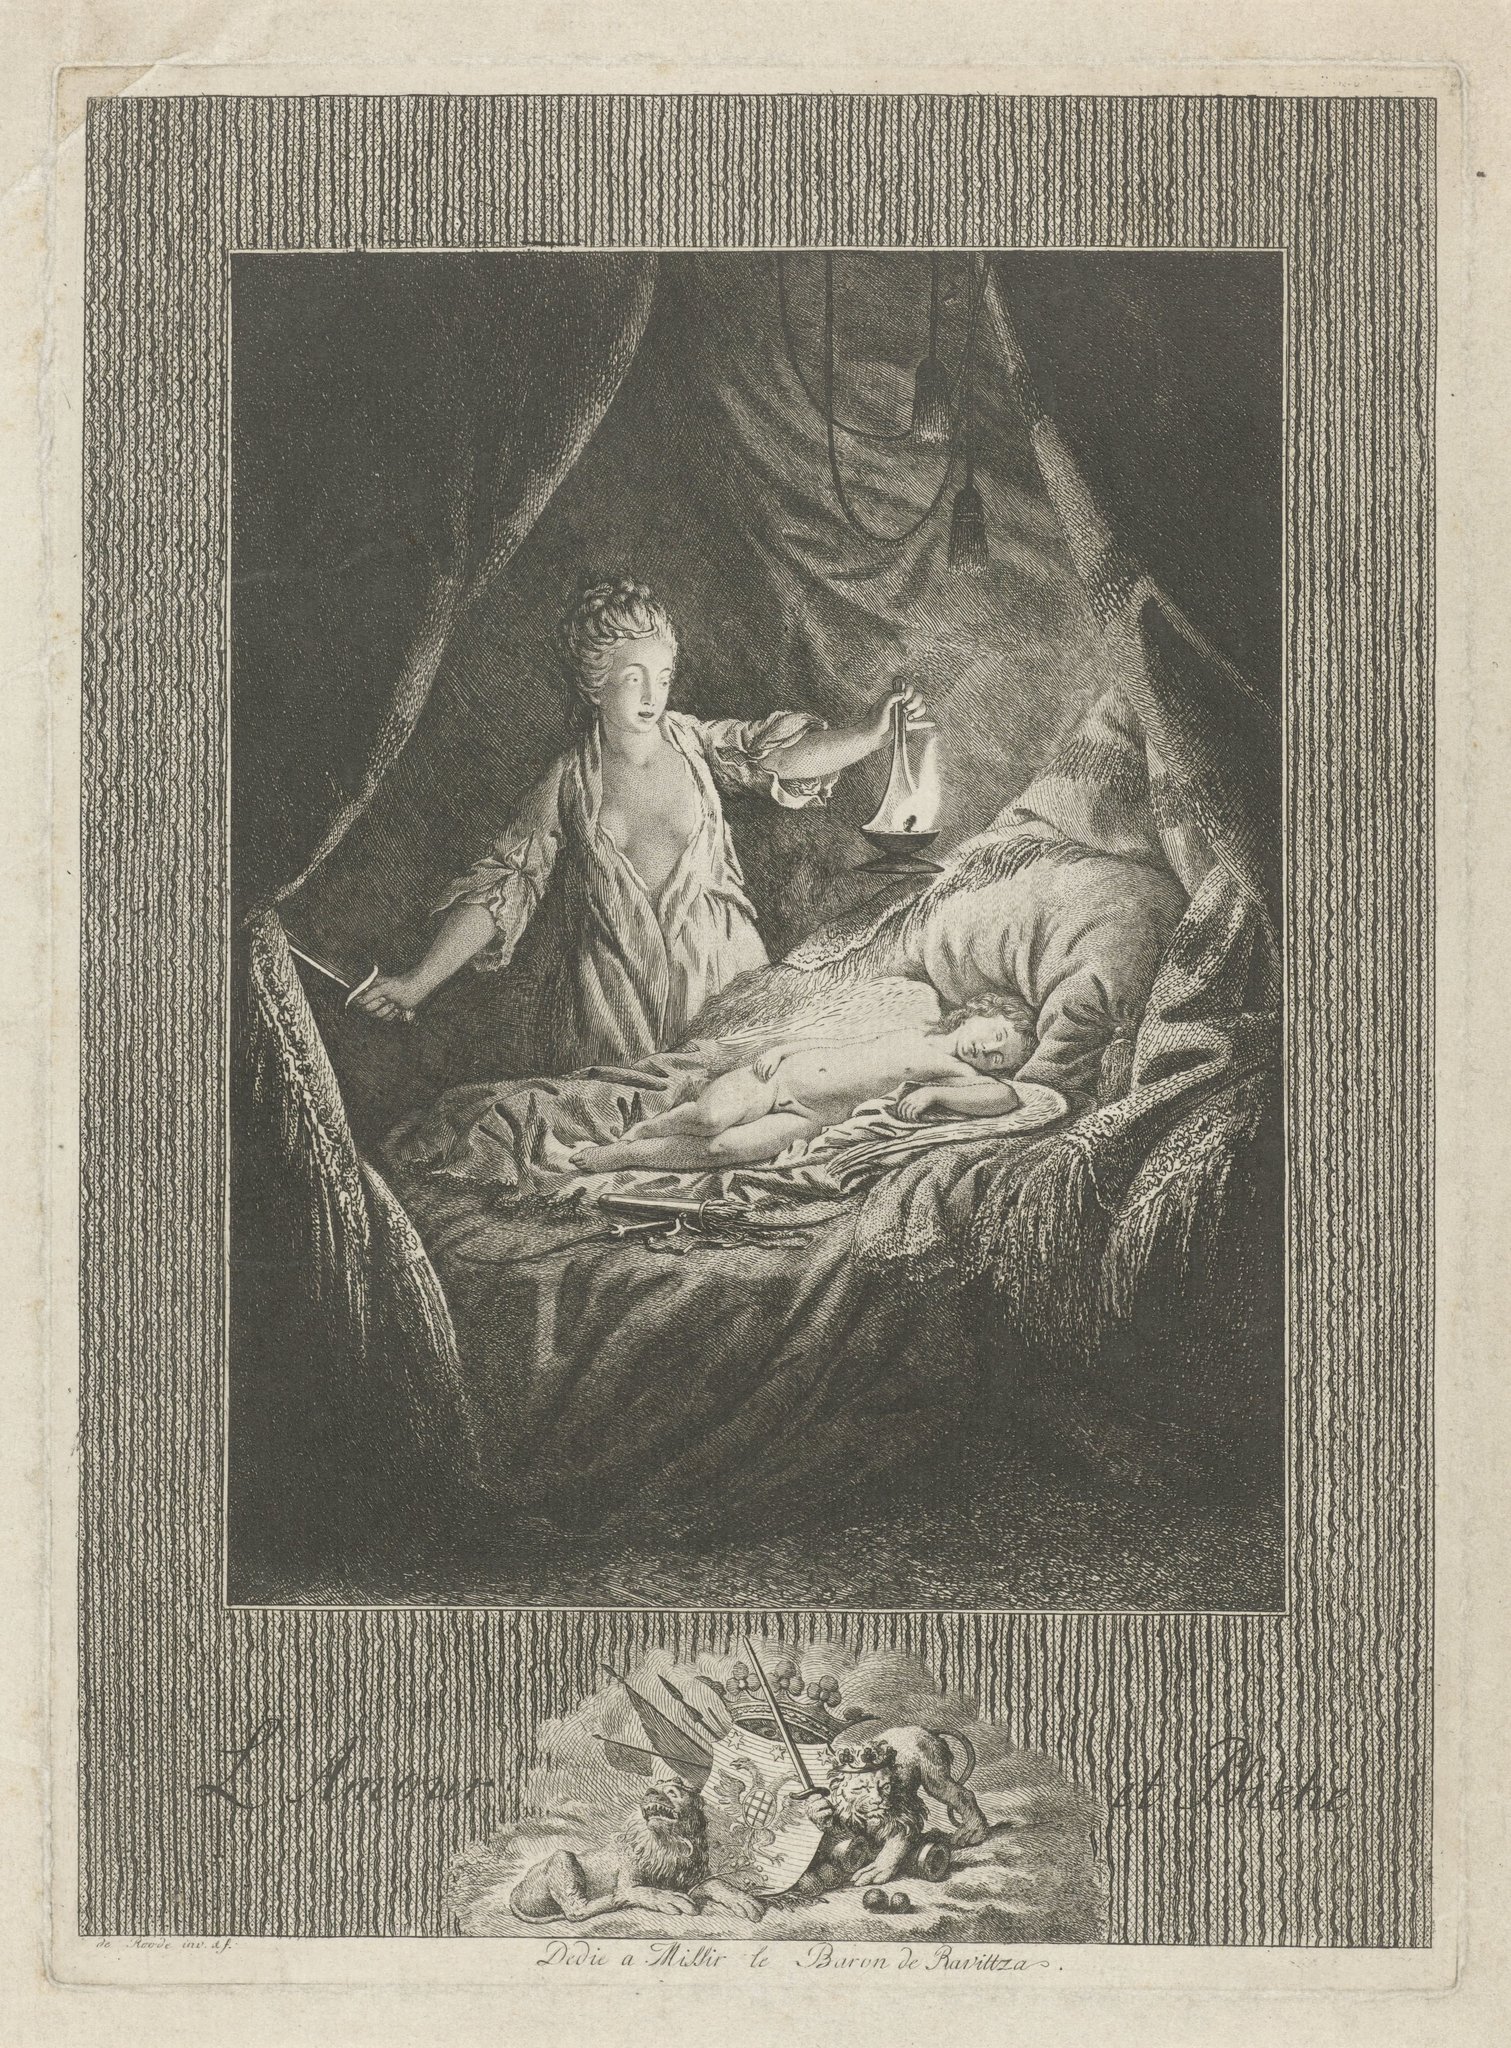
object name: print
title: Amor en Psyche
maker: theodorus de roode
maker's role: draughtsman, print maker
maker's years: 1736-1793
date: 1746-1793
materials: paper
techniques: etching, roulette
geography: netherlands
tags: sleeping; unconsciousness, psyche, holding a lamp, gazes at the sleeping cupid, who awakens when a drop of hot oil falls on him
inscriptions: collector's mark: Lugt 2228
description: Psyche bespiedt de god Amor in zijn slaap. Zij heeft een olielamp en een dolk in haar handen. Psyche schrikt door de schoonheid van Amor en knoeit een druppel olie uit haar lamp. Onder de voorstelling het wapen van de baron van Ravittza.